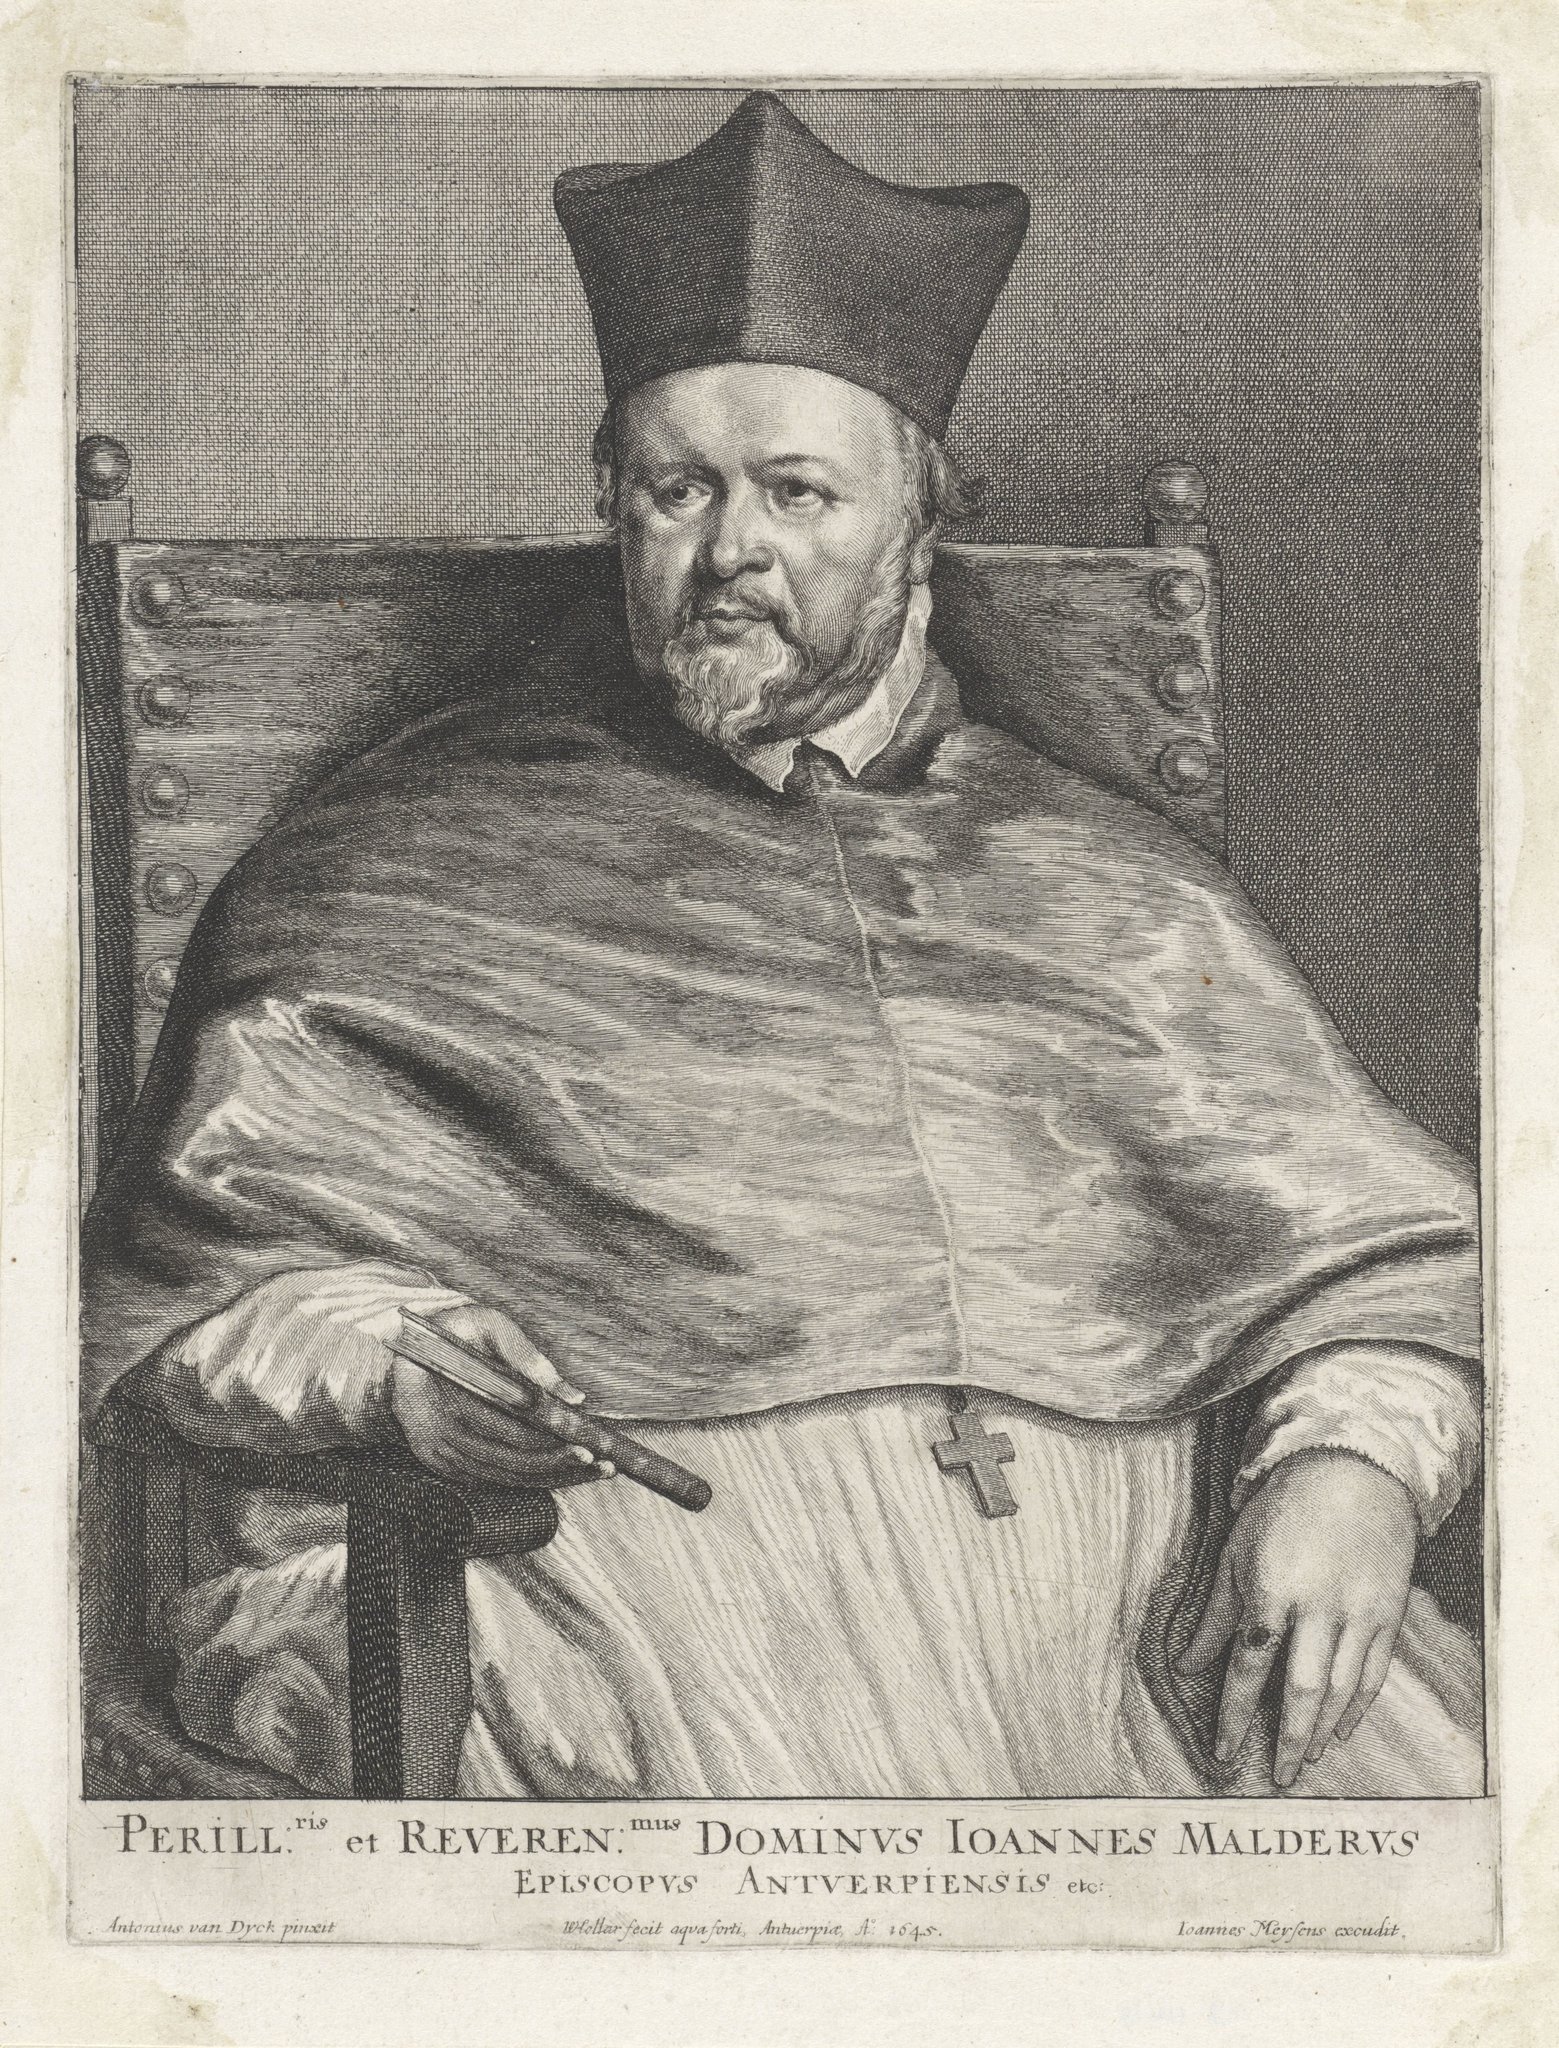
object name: print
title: Portret van Johannes Malderus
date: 1645-1670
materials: paper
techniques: etching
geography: antwerp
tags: johannes malderus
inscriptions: collector's mark: Lugt 240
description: De prent maakt deel uit van een zevendelige serie portretten naar Anthony van Dyck, uitgegeven door Joannes Meyssens.